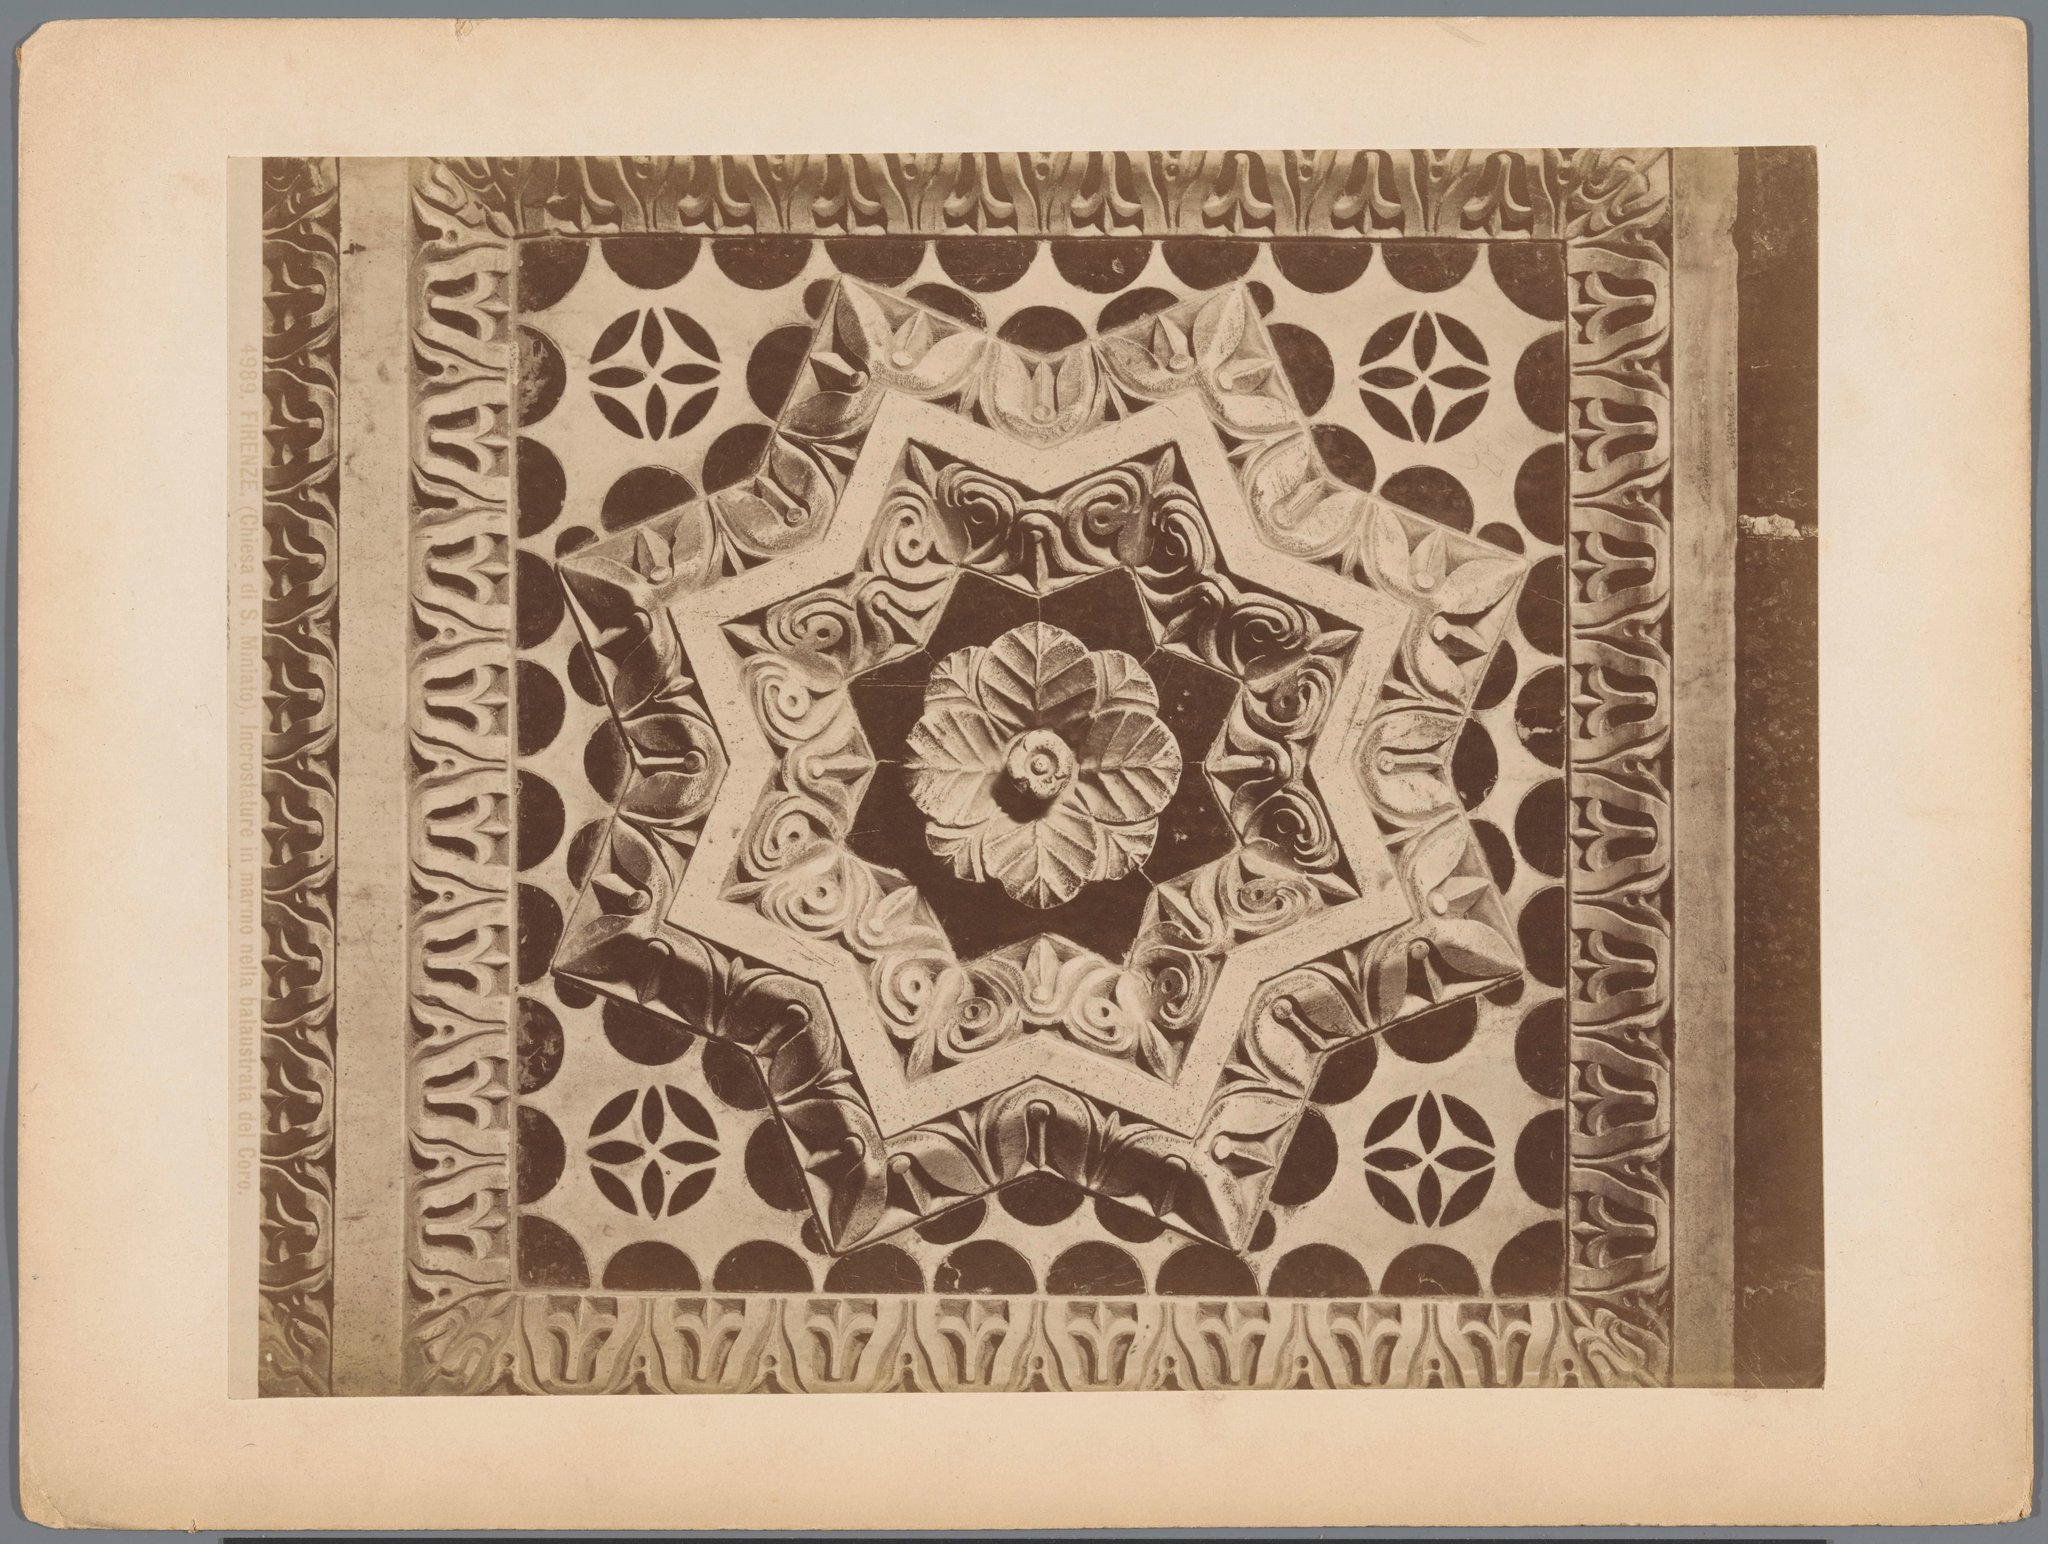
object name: photograph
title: FIRENZE. (Chiesa di S. Miniato). Incrostature in marmo nella balaustrata del Coro.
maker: Anonymous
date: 1875-1900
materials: cardboard, photographic support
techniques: albumen print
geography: s. miniato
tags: ornaments ~ art, ornament ~ starforms, decorating 'en relief', appliquéing, parts of church interior: choir, flowers ~ ornament, sculpture (+ relief ~ sculpture)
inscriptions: collector's mark: Lugt 3937, number: ‘4989.’